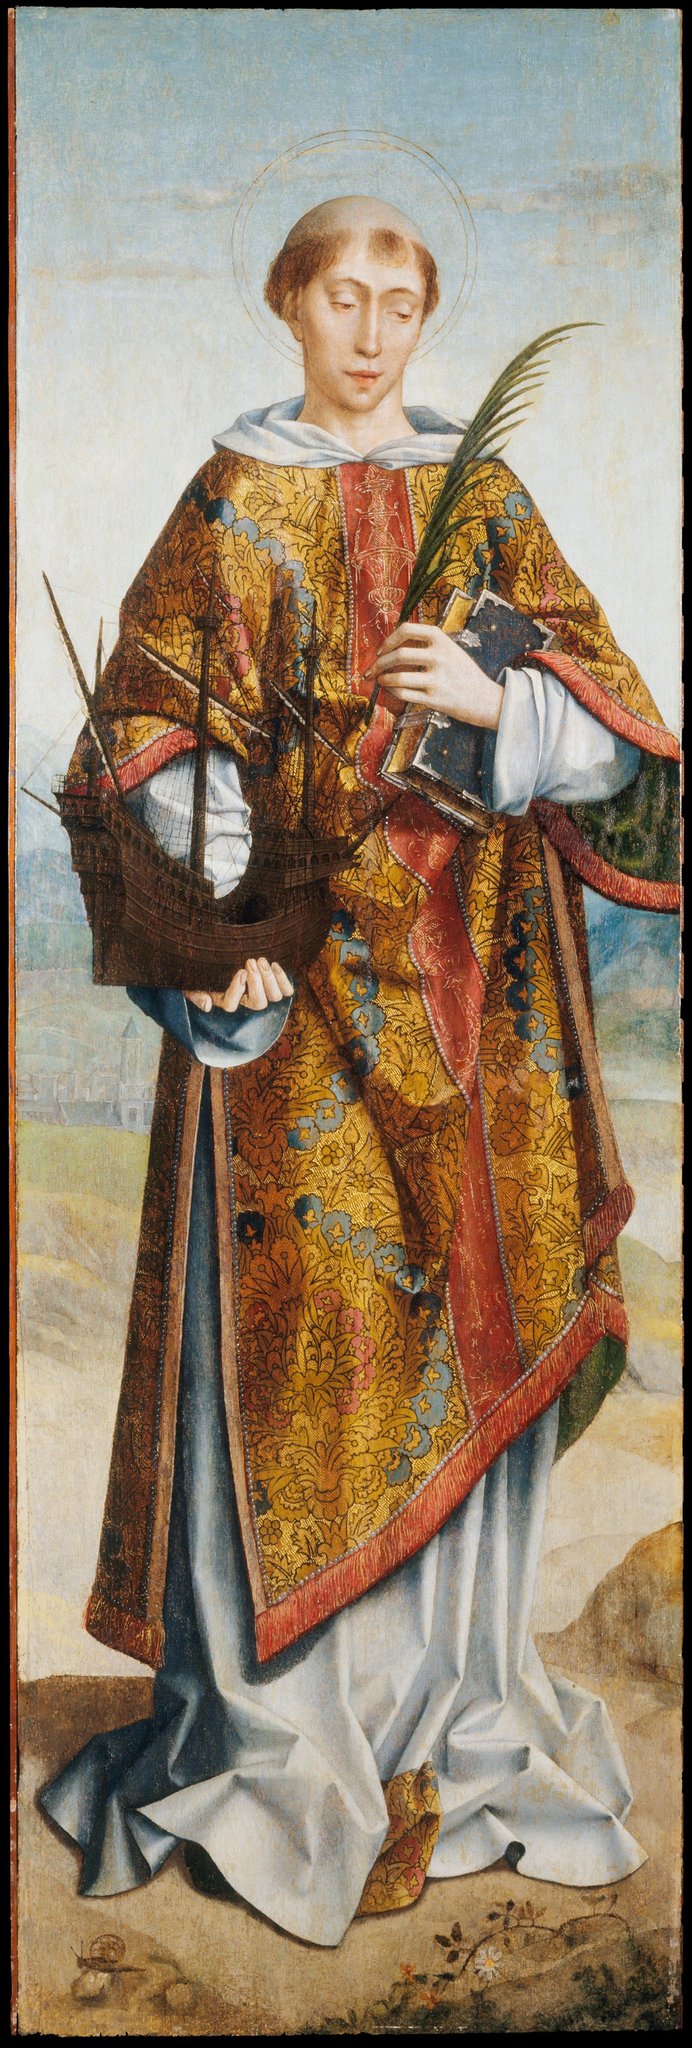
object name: painting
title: Saint Vincent, Patron Saint of Lisbon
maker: frei carlos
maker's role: artist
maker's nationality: portuguese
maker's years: 1525-1549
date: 1525-1549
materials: oil, wood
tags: books,saints,ships